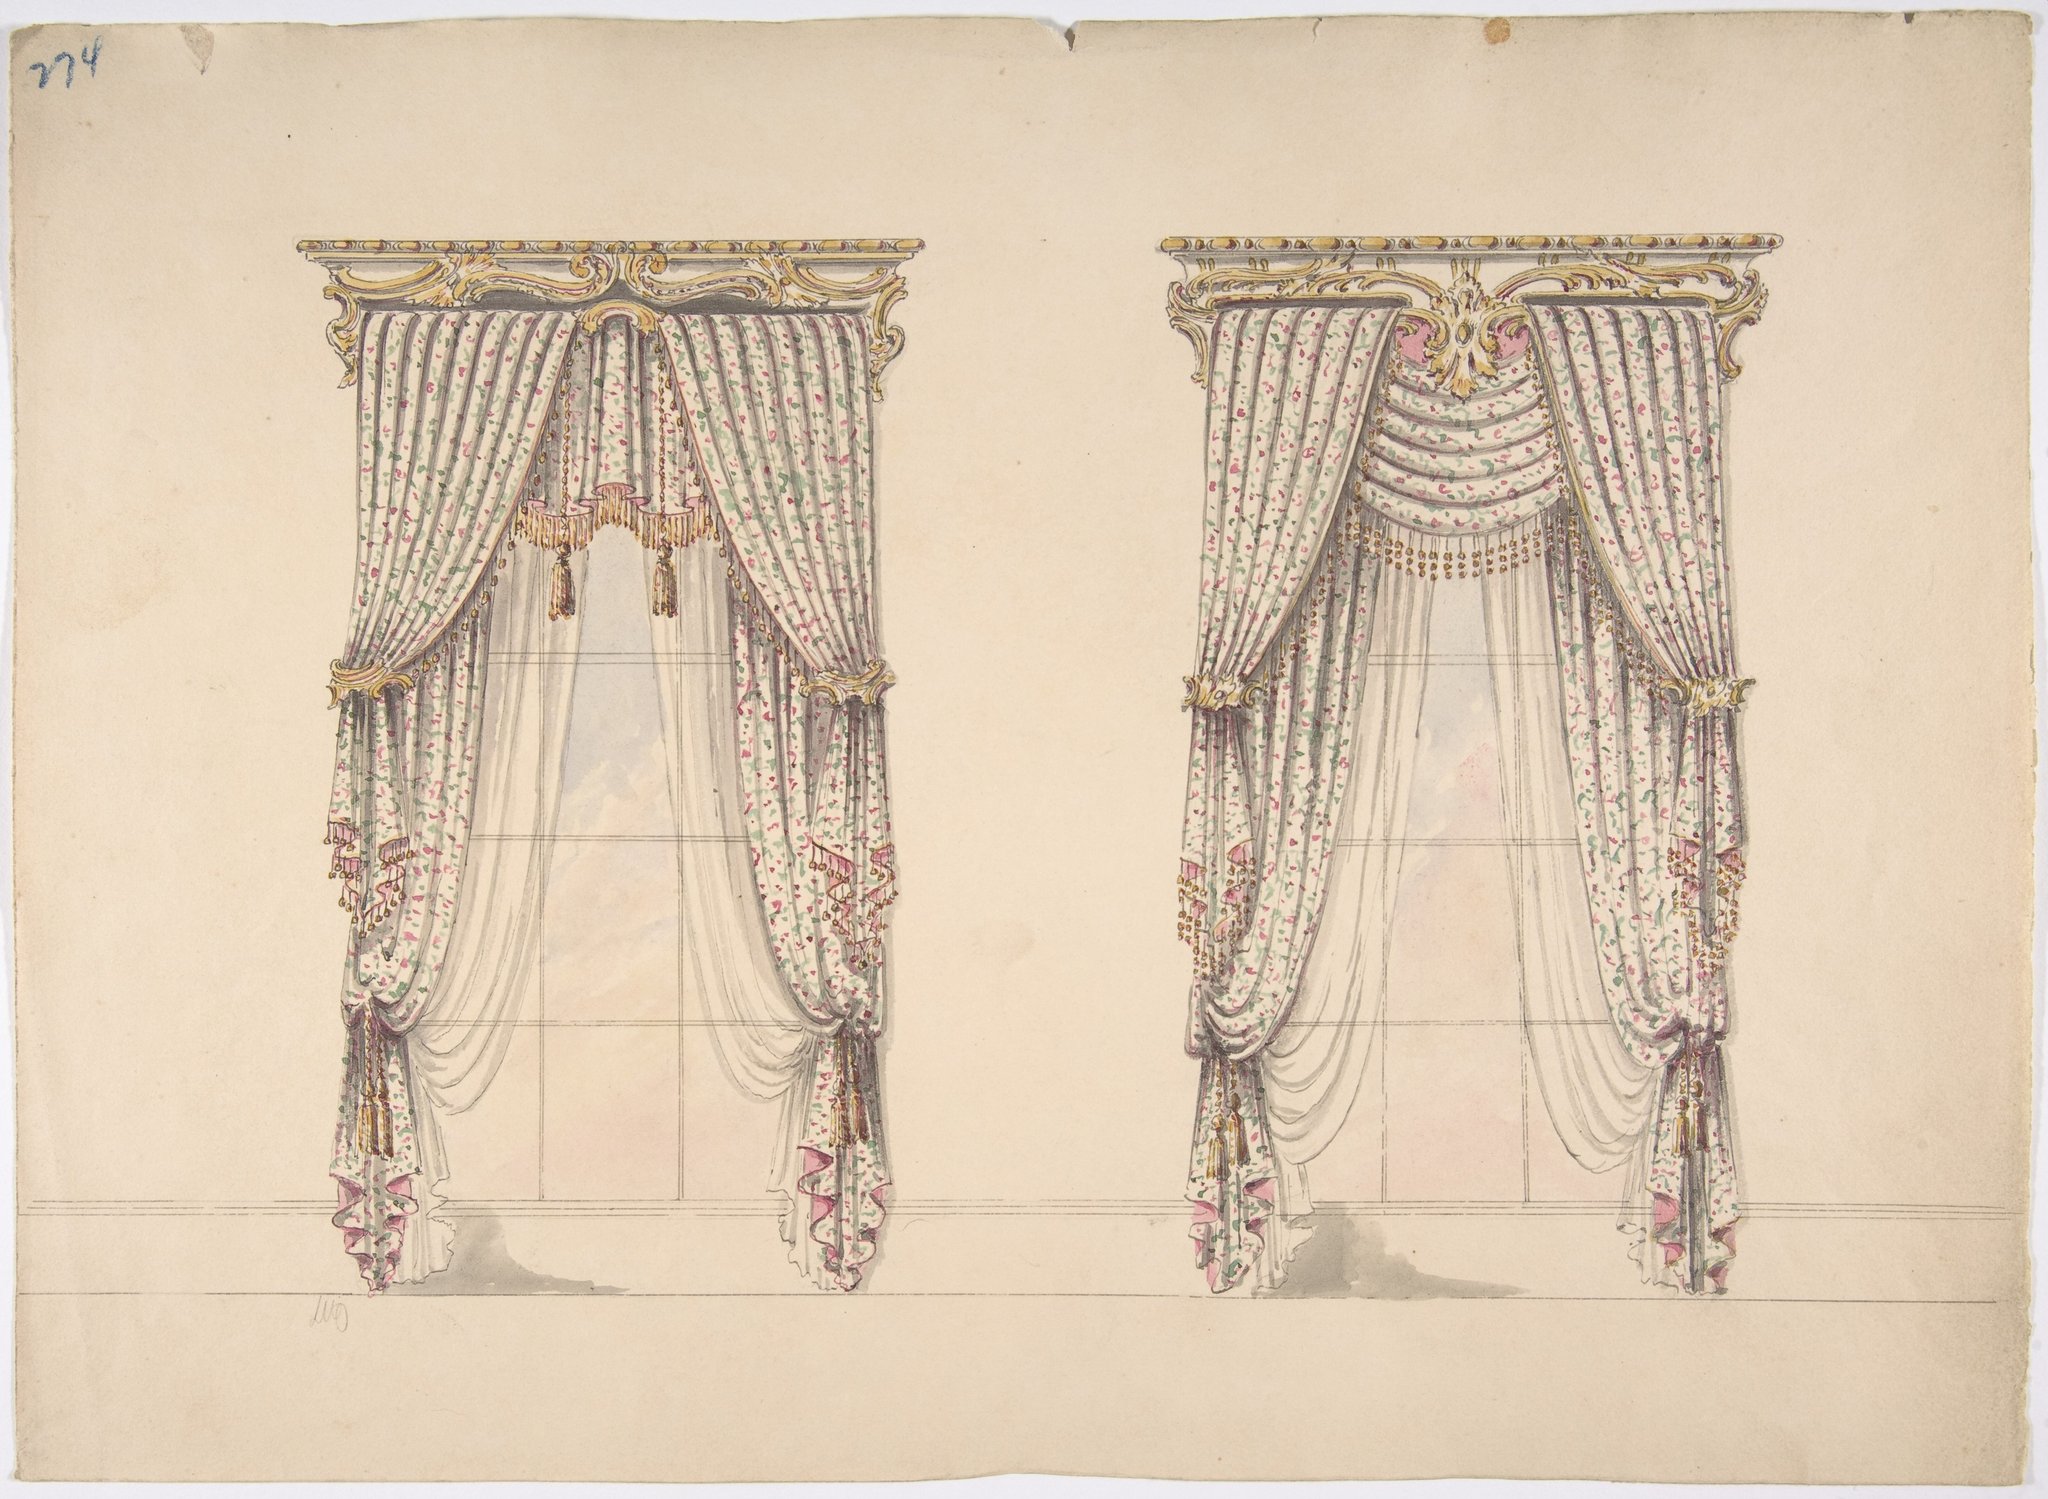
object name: drawing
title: Design for Pink, Green and White Curtains with Pink and Gold Fringes and a Gold and White Pediment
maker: anonymous, british, 19th century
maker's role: artist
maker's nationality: british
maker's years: 1800-1900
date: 1801-1833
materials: ink, watercolor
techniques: brush, pen, wash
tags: curtains